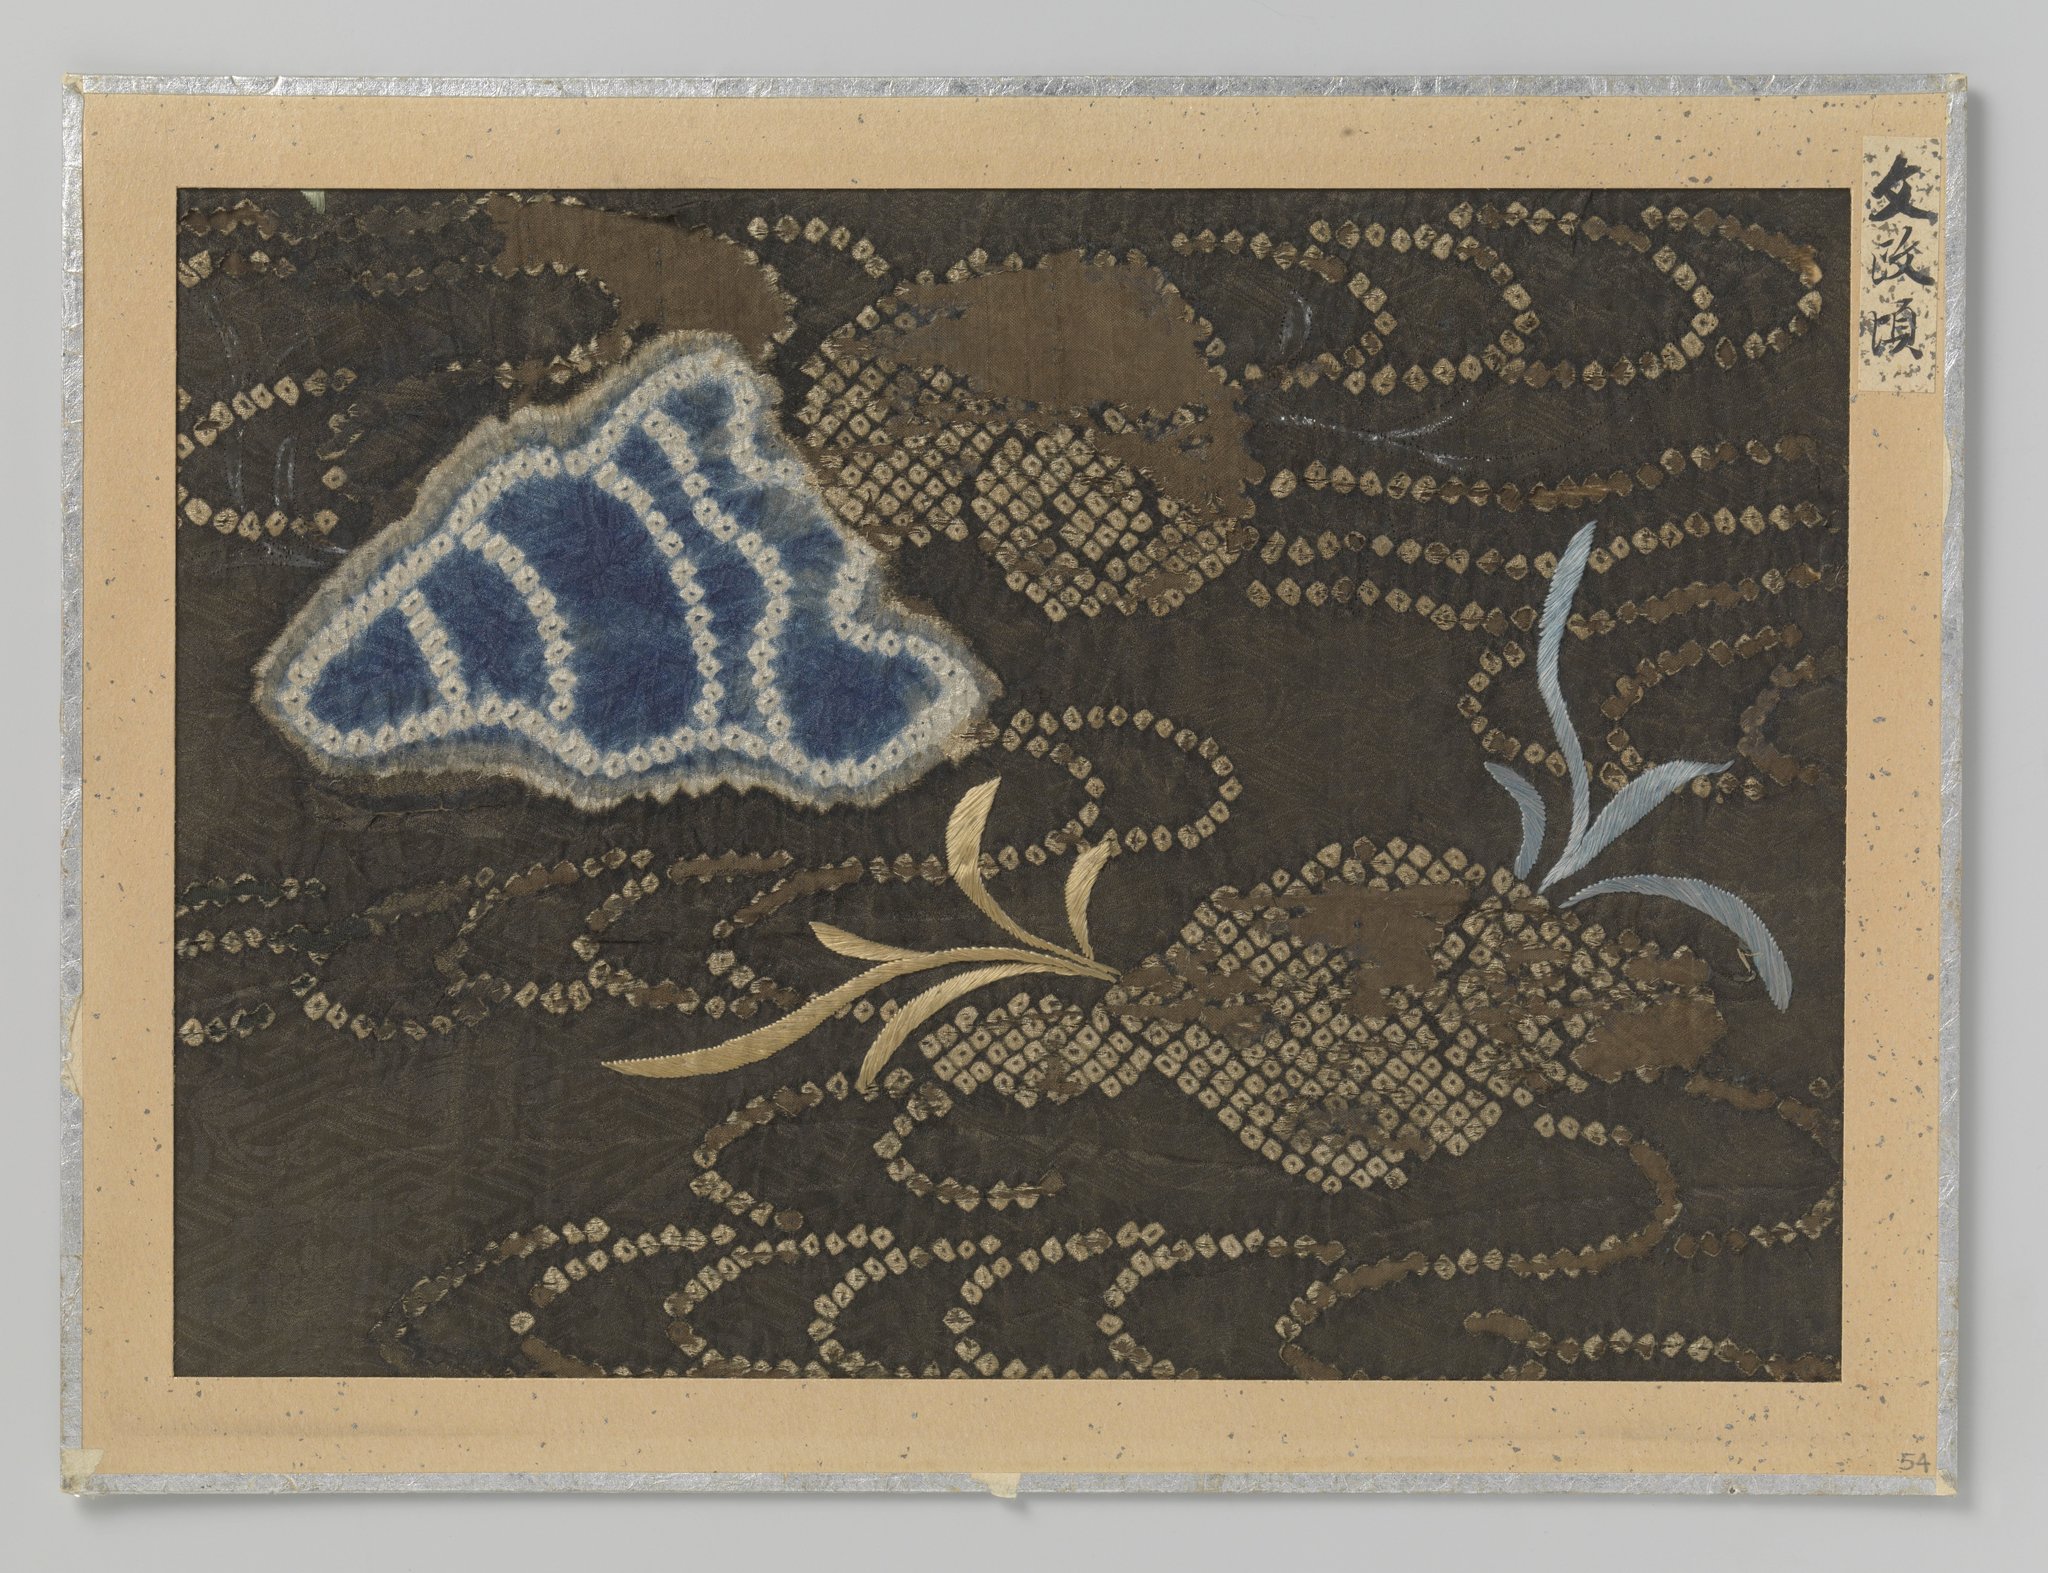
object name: fragment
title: Fragment textiel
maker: Anonymous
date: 1818-1830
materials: silk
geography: japan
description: Textielfragment, druk en borduursel op donkerbruin fond.